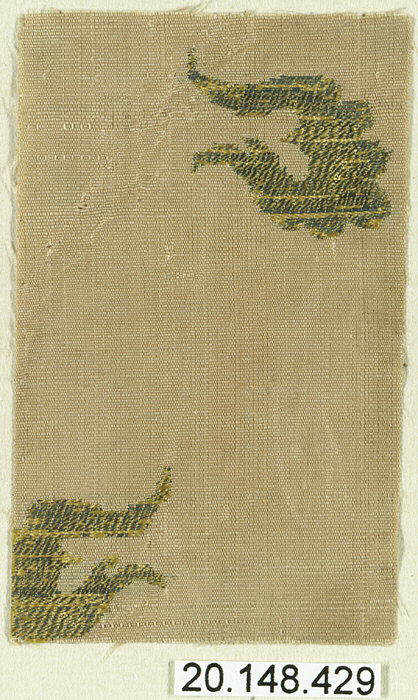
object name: piece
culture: japanese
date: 1701-1800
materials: silk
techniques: compound weave